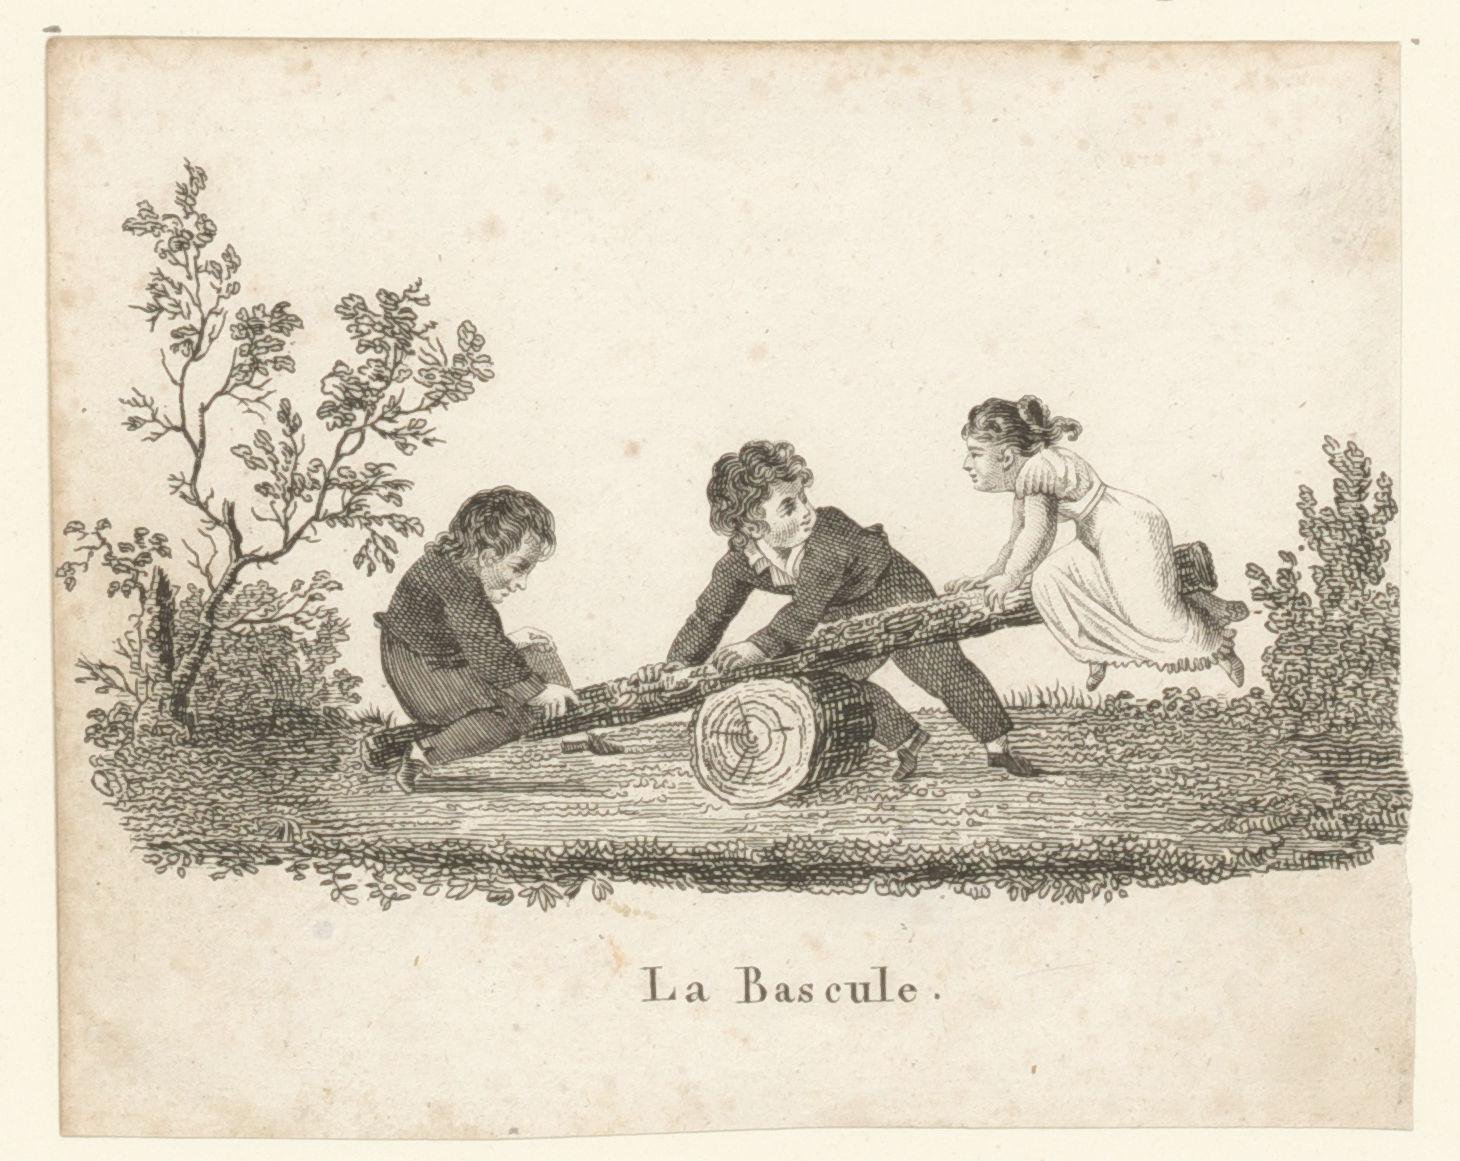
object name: print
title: La Bascule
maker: Anonymous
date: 1800-1899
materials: paper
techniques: etching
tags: children's games and plays, seesaw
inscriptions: stamp, collector's mark: Lugt 1641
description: Onderwerpsrubrieken binnen de Atlas Zeden en Gewoonten: Zeden en Gewoonten in Engeren Zin, Des menschen beging, midden en einde, Kinderleven – Kinderspel en Kinderprenten.